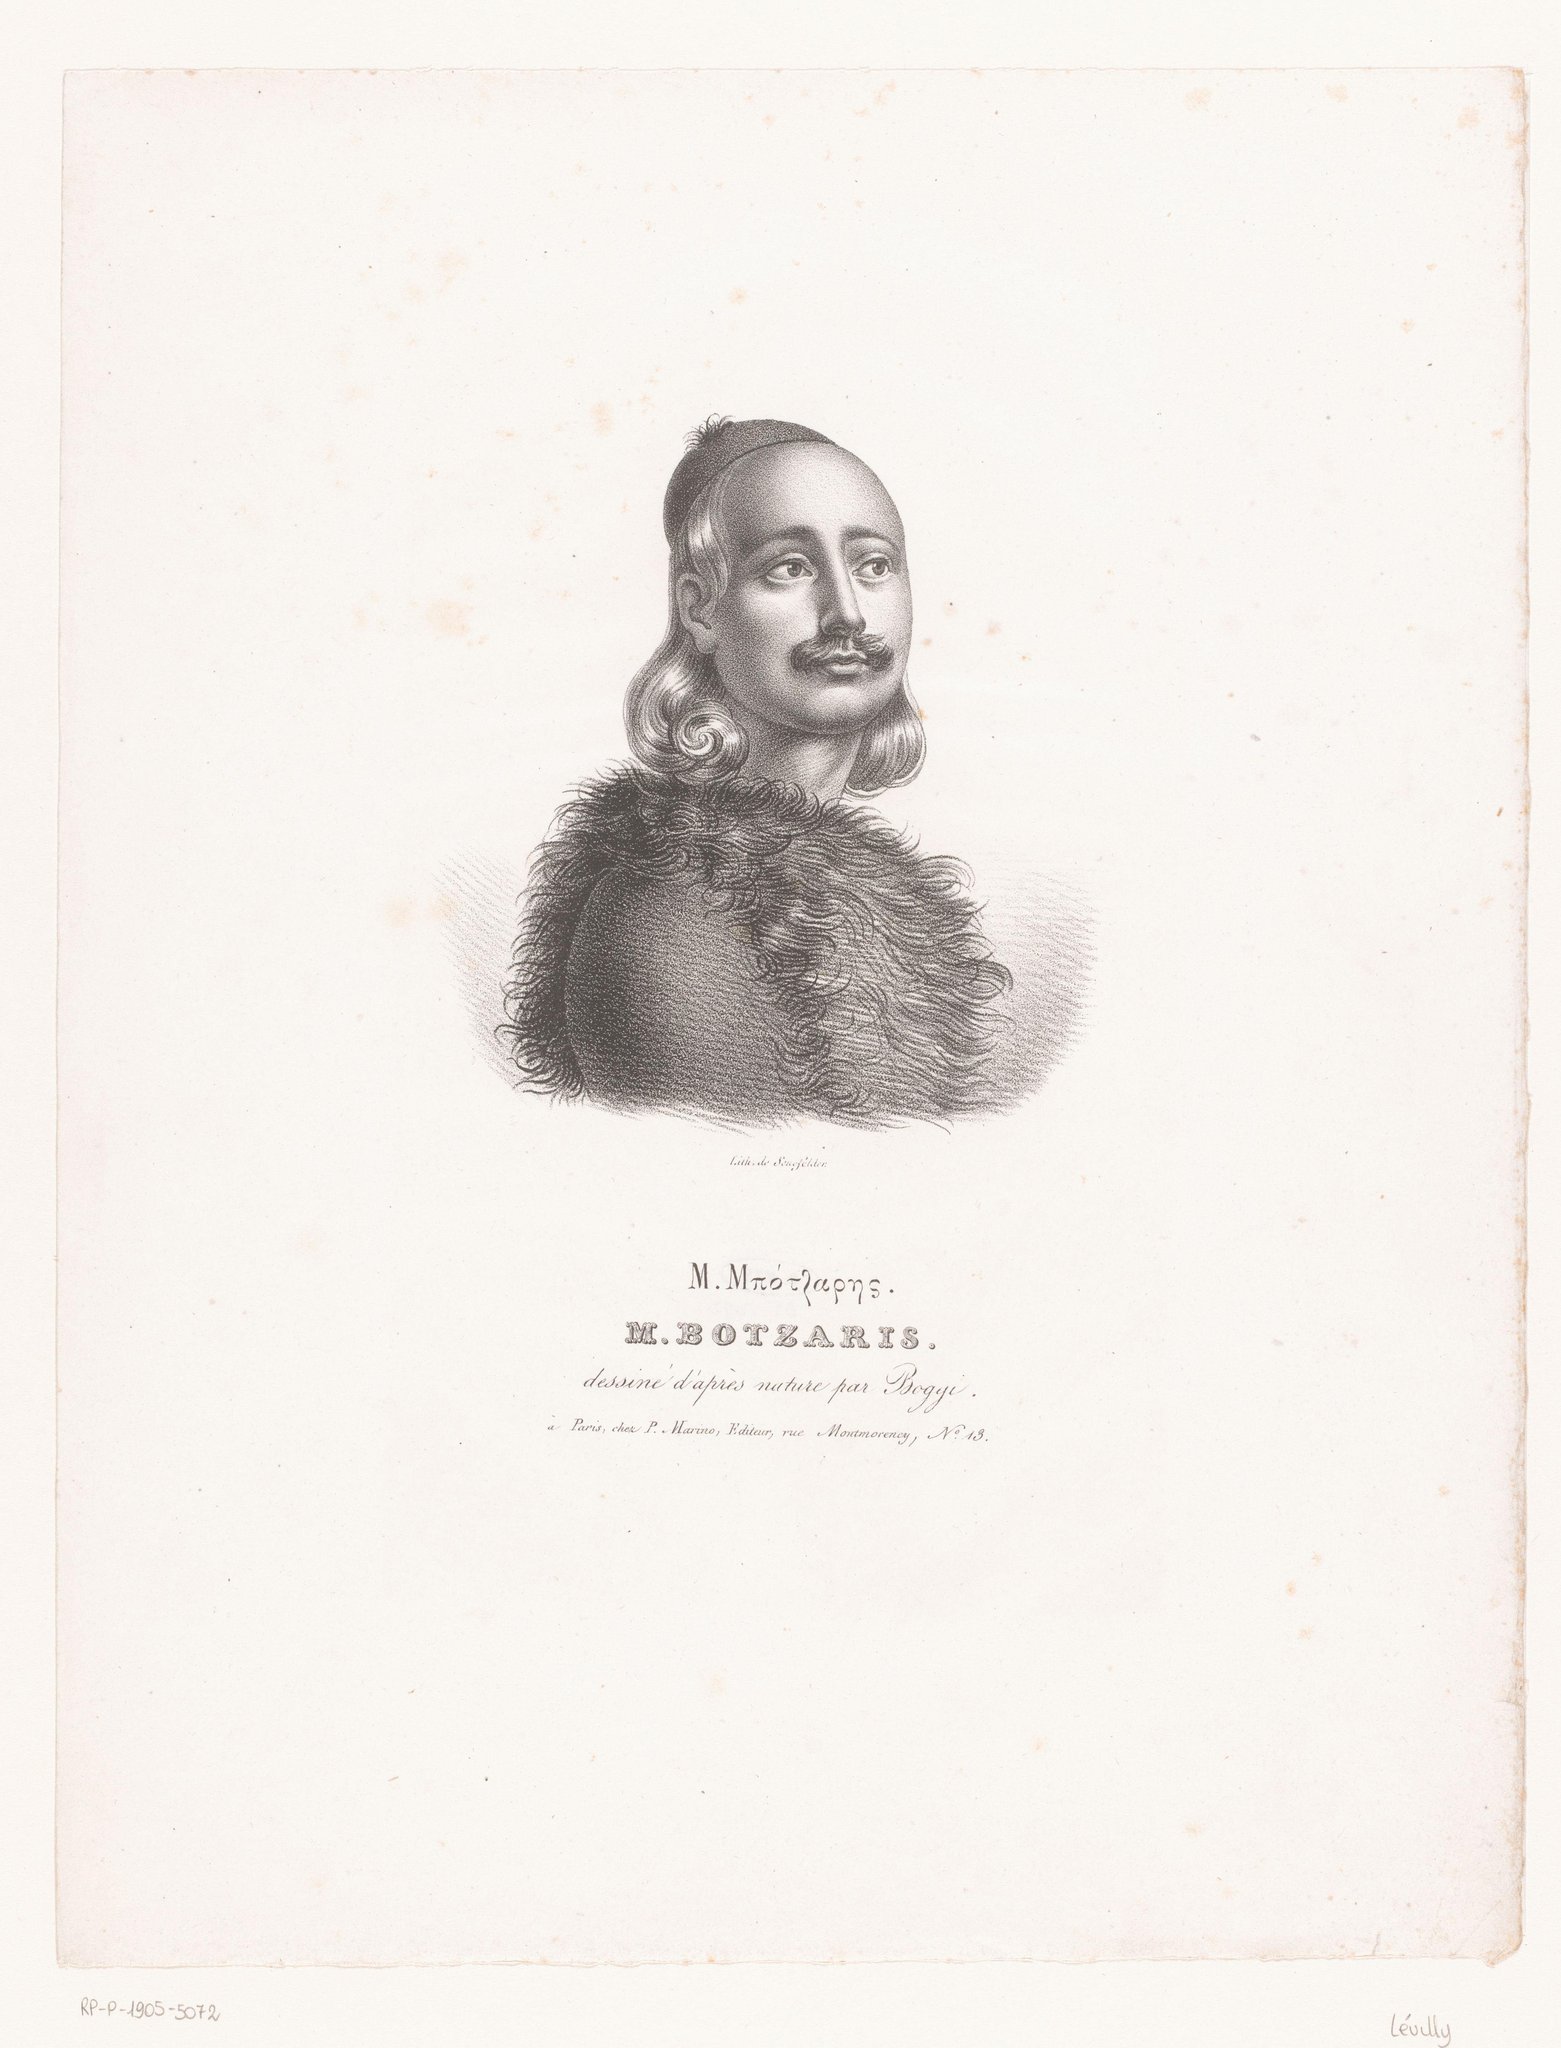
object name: print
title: M. Botzaris, dessiné d'après nature par Boggi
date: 1827-1829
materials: paper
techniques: lithograph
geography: paris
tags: historical persons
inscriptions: collector's mark: Lugt 2228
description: Mogelijke toeschrijving aan Lévilly op basis van vergelijkbare prenten uit zijn oeuvre.